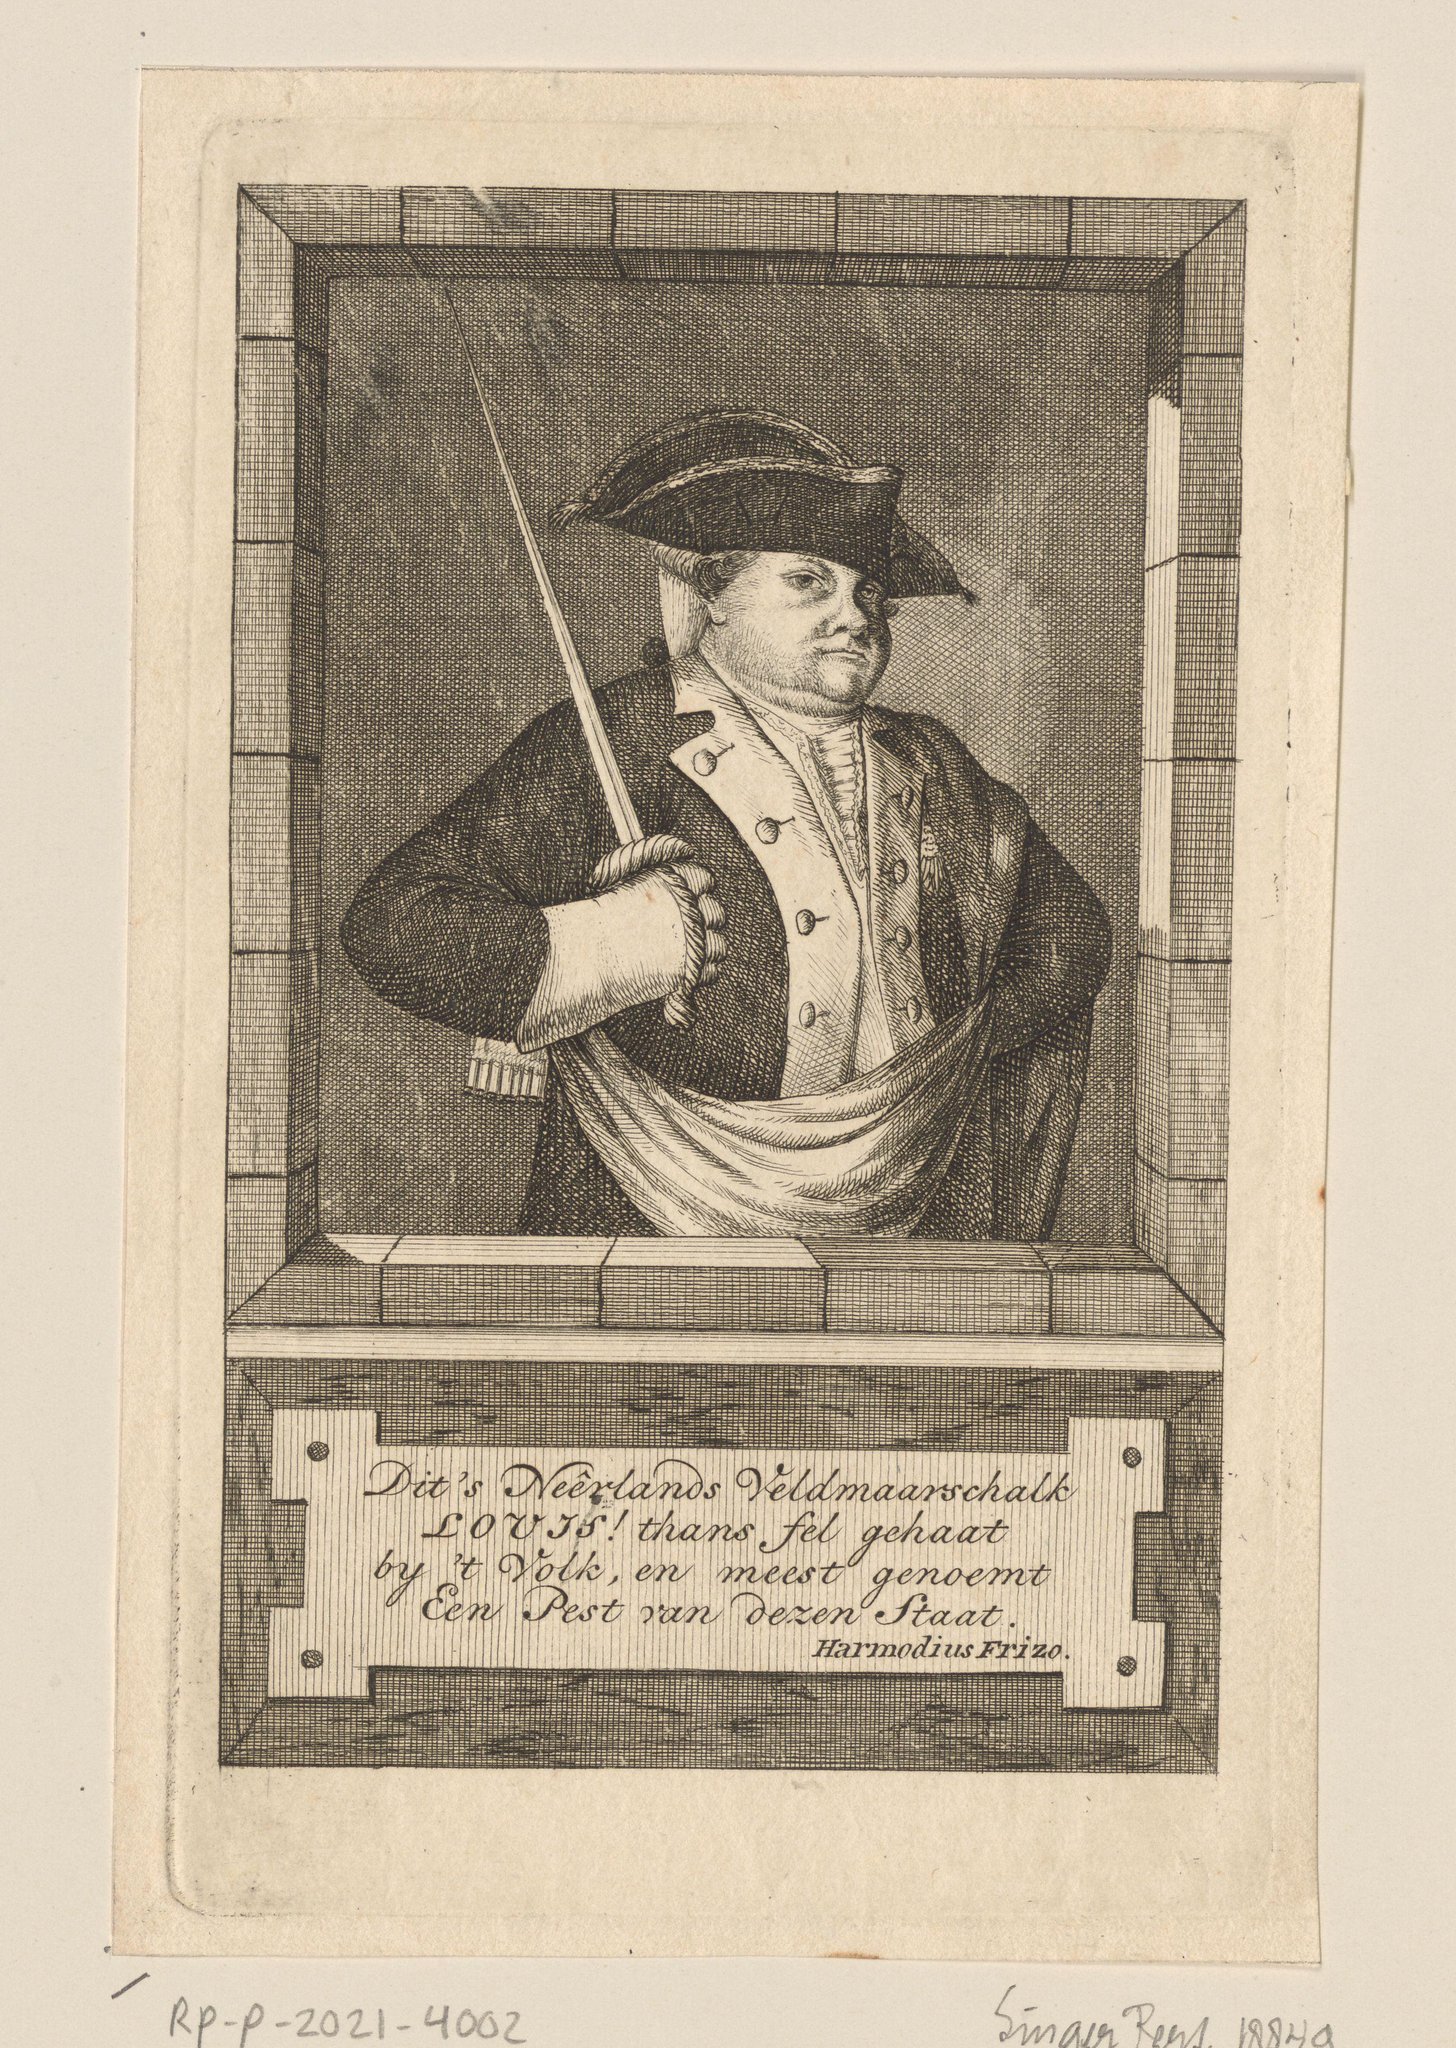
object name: cartoon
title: Portret van Lodewijk Ernst, hertog van Brunswijk-Wolfenbüttel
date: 1778-1784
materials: paper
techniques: etching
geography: netherlands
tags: ludwig ernst von braunschweig-wolfenbüttel, historical persons, hacking and thrusting weapons: rapier, political caricatures and satires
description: Met vierregelig spotgedicht in het Nederlands.